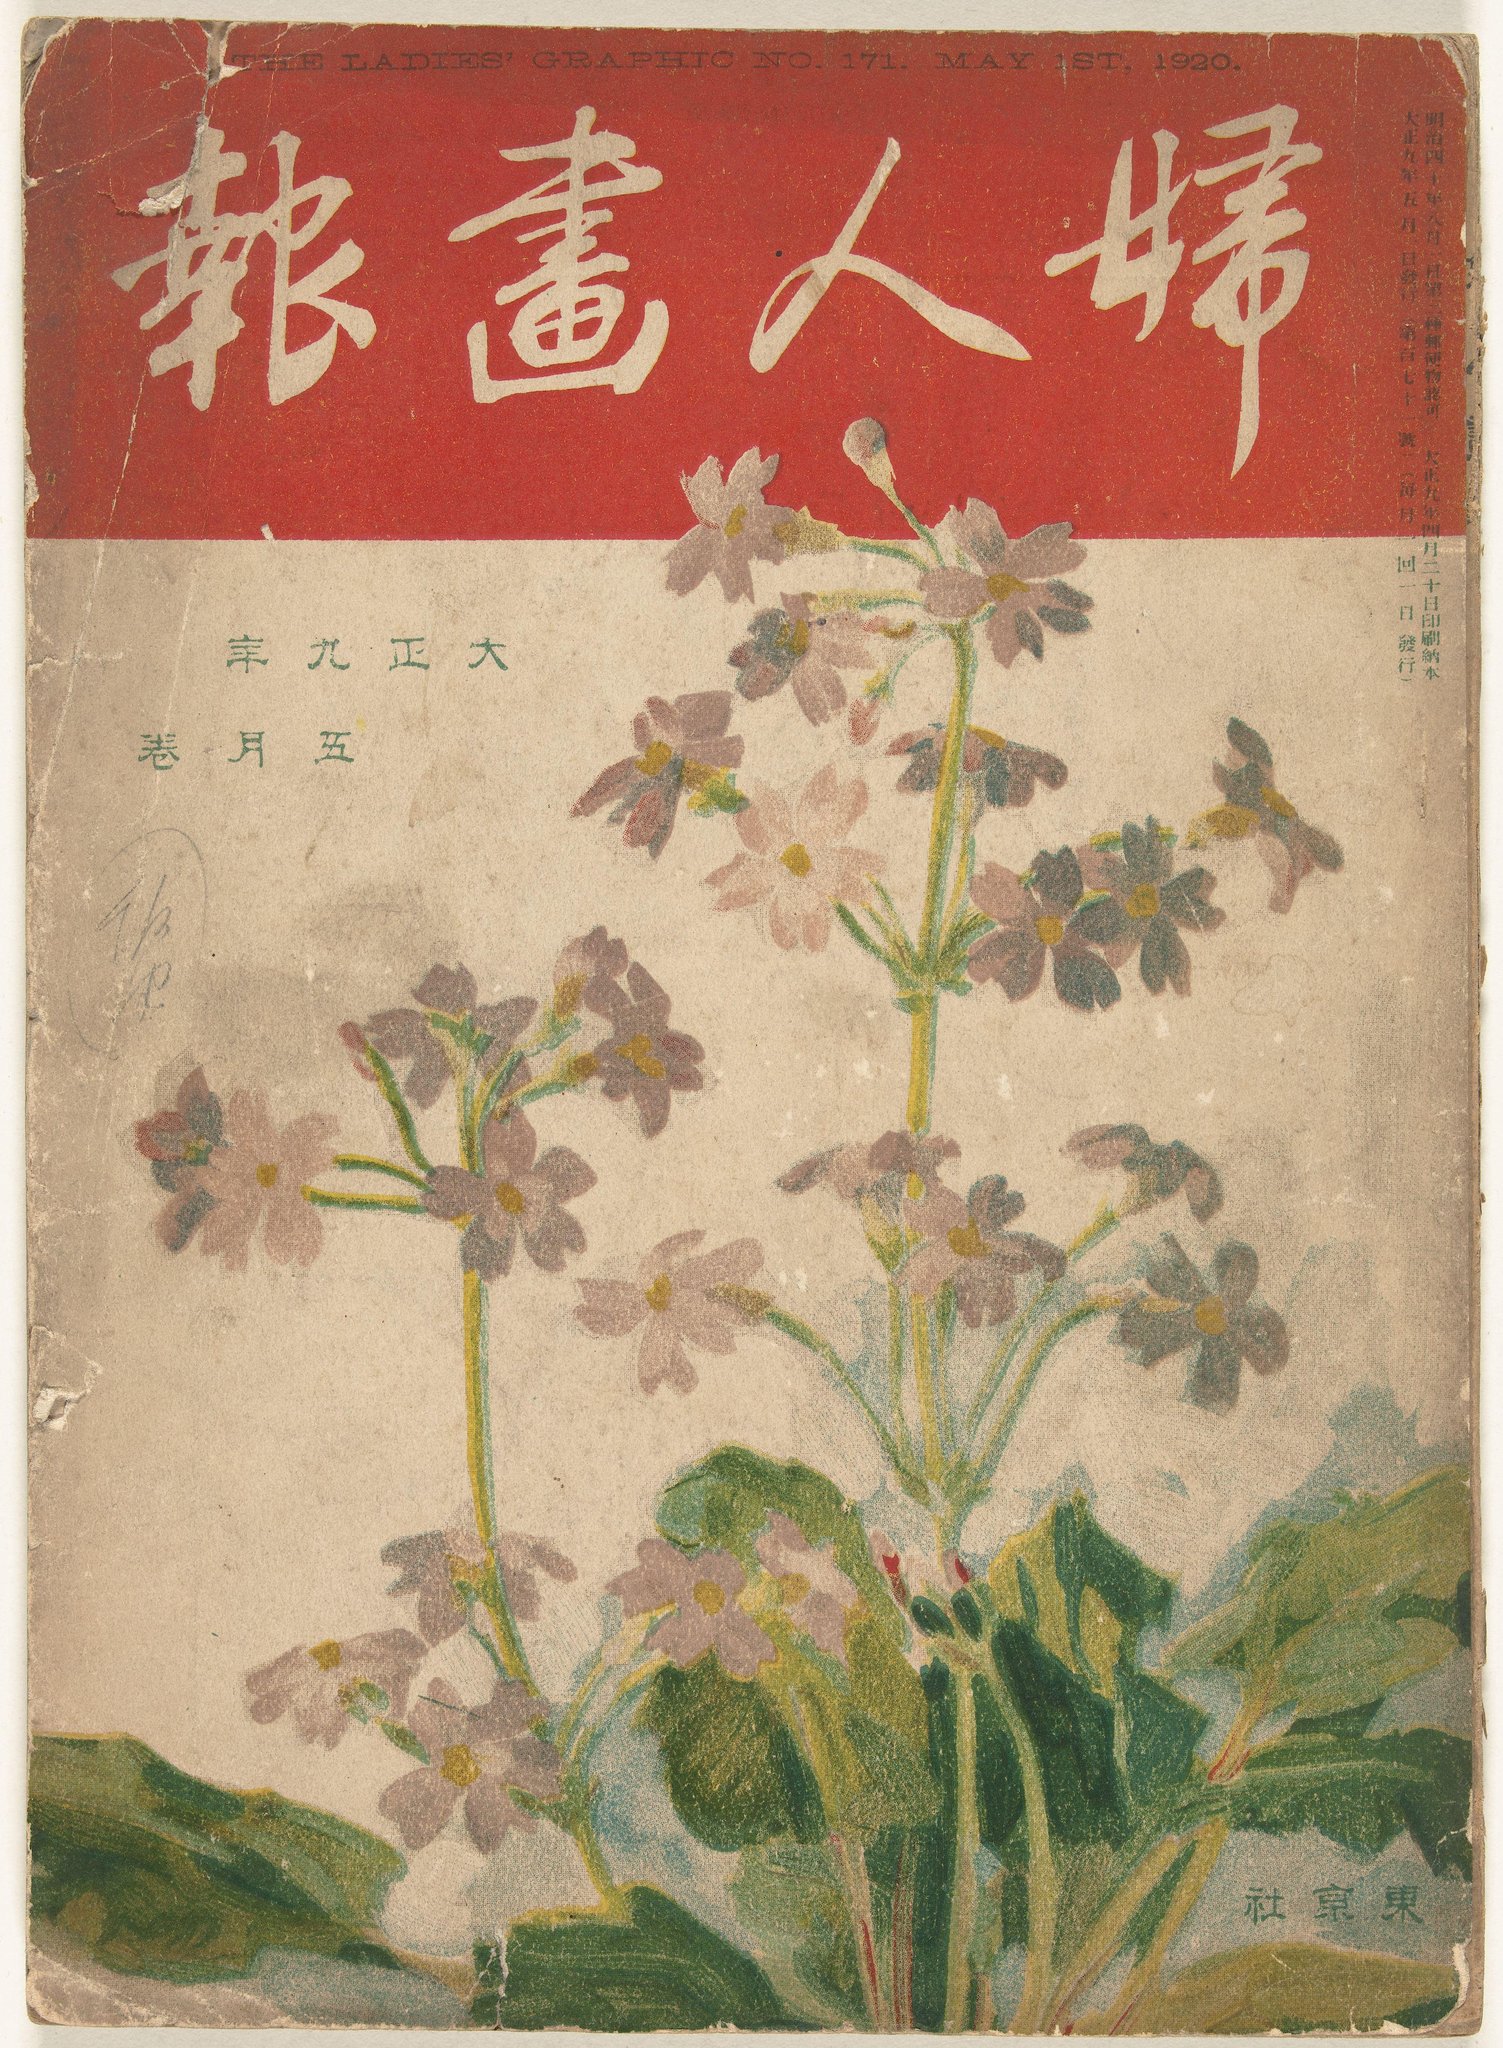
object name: magazine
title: Fujin gaho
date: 1920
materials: paper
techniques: letterpress printing, planographic printing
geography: japan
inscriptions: date